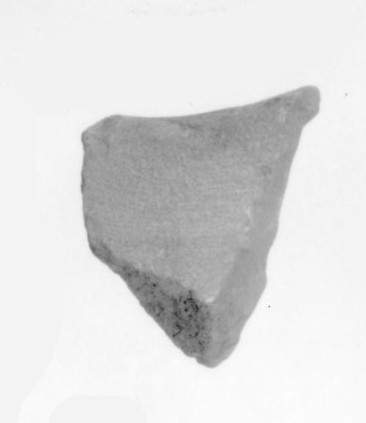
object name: canopic box, siptah, top surface, inner surface, jar lip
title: Fragment of the Top Surface of Siptah's Canopic Chest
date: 1194-1188 BCE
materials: stone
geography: egypt